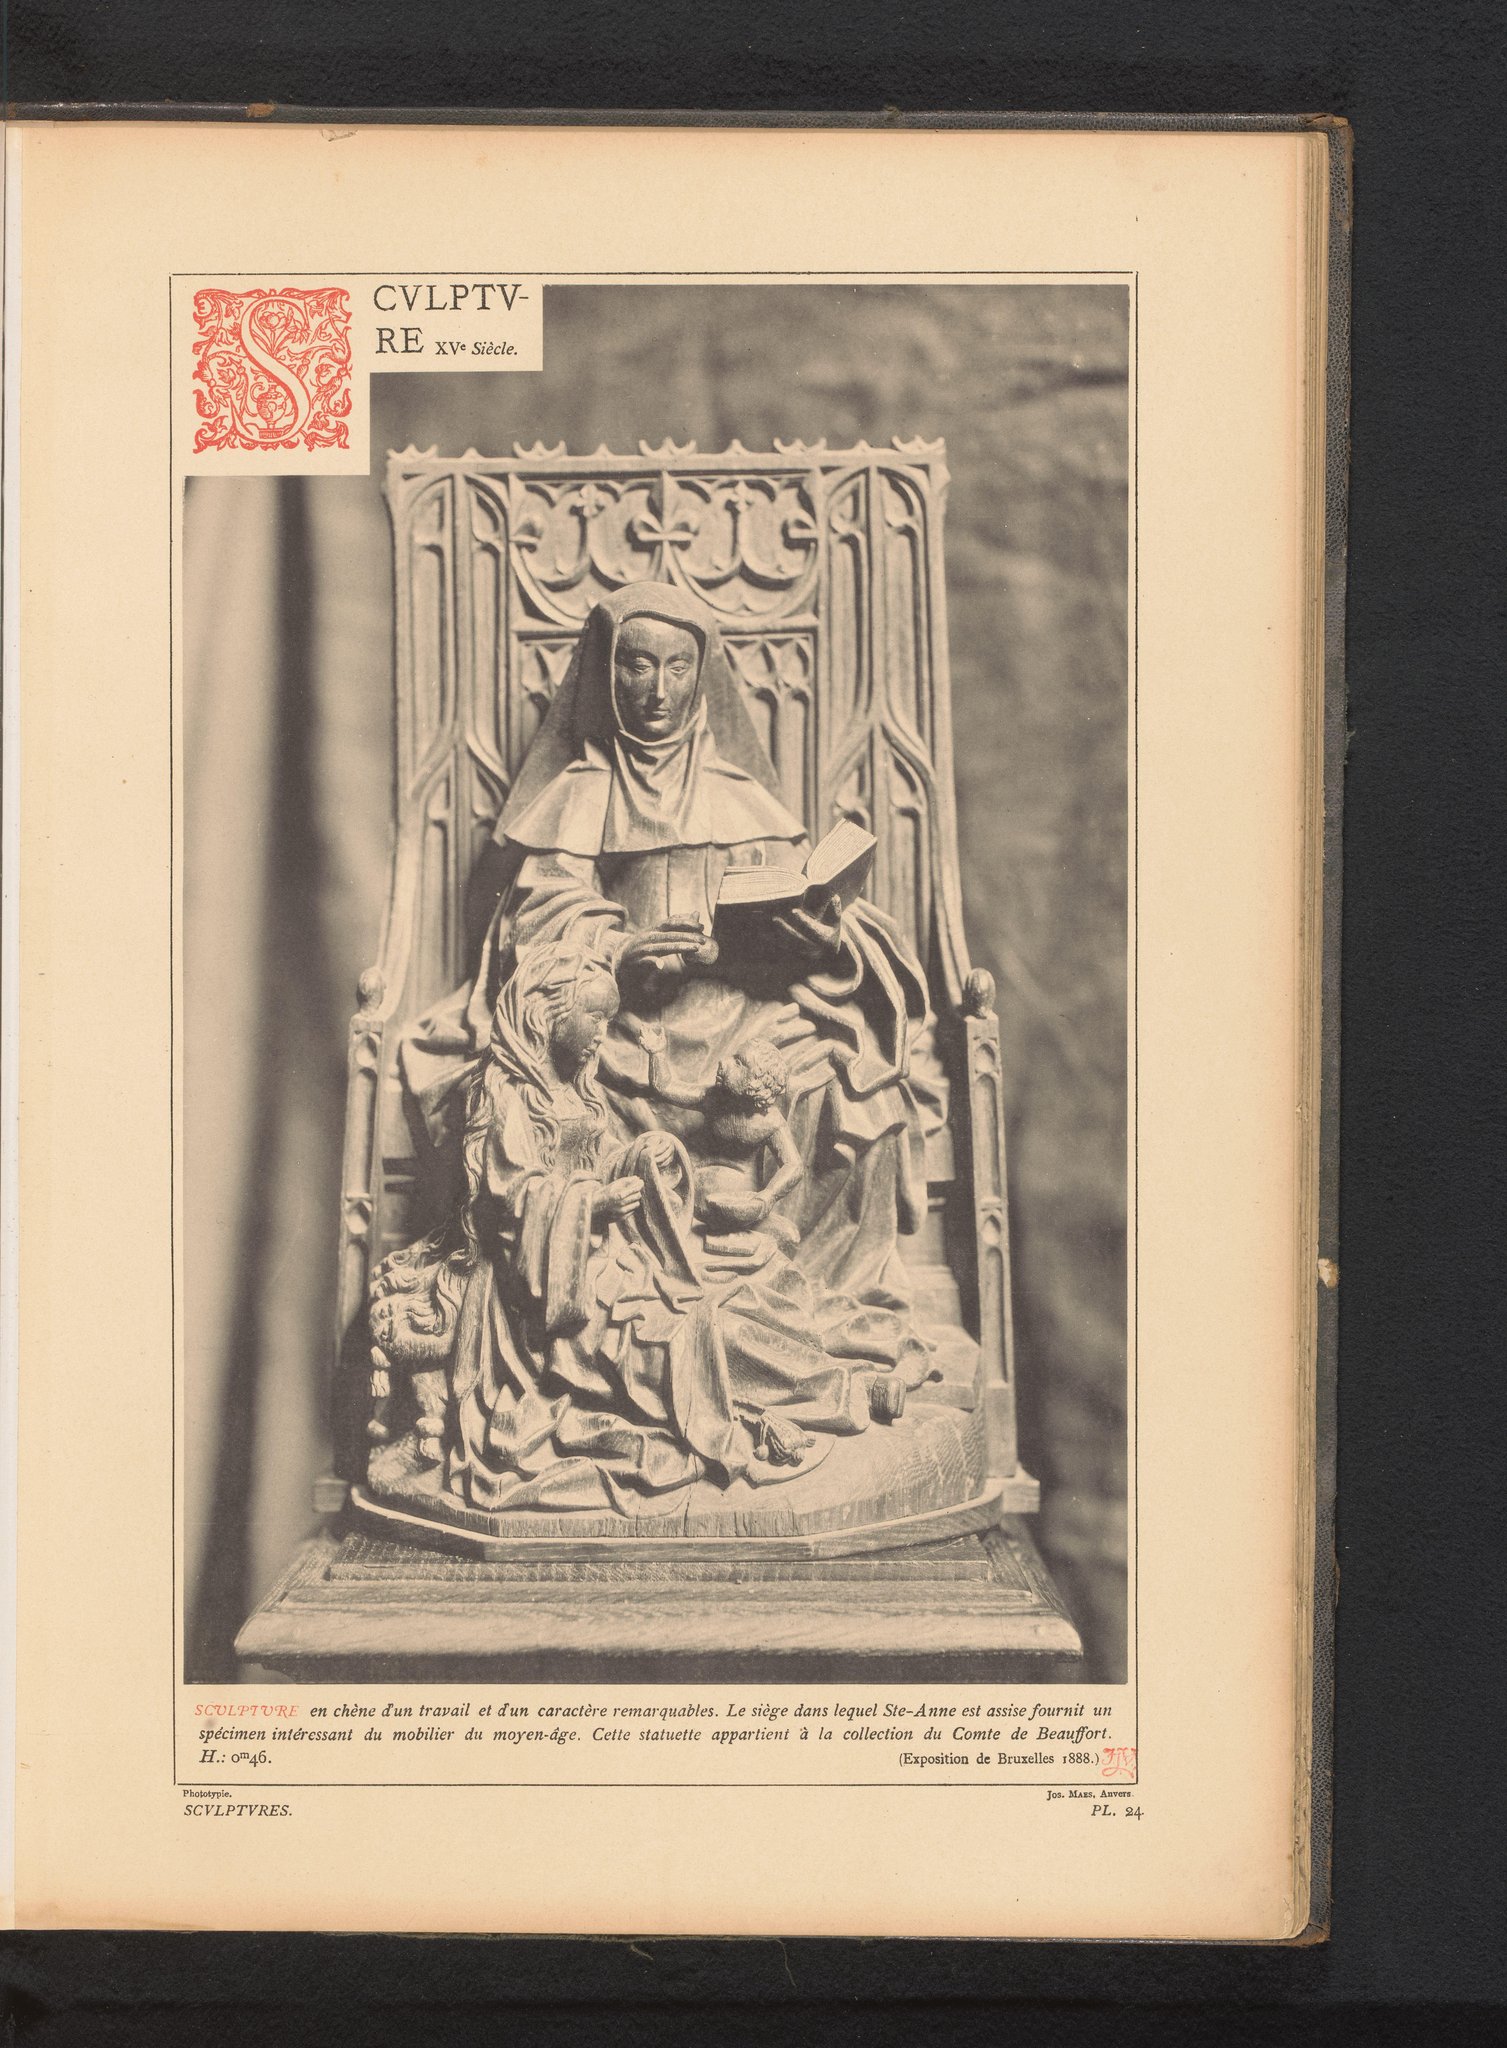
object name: photomechanical print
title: Sculptures, XVIe Siècle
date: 1881-1889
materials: paper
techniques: photograph, photolithography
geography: antwerp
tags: sculpture, story of joachim and anna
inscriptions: inscription: ‘SCULPTURES. PL. 24.’, monogram: ‘JJvY’, inscription: ‘SCULPTURE en chène (...)’